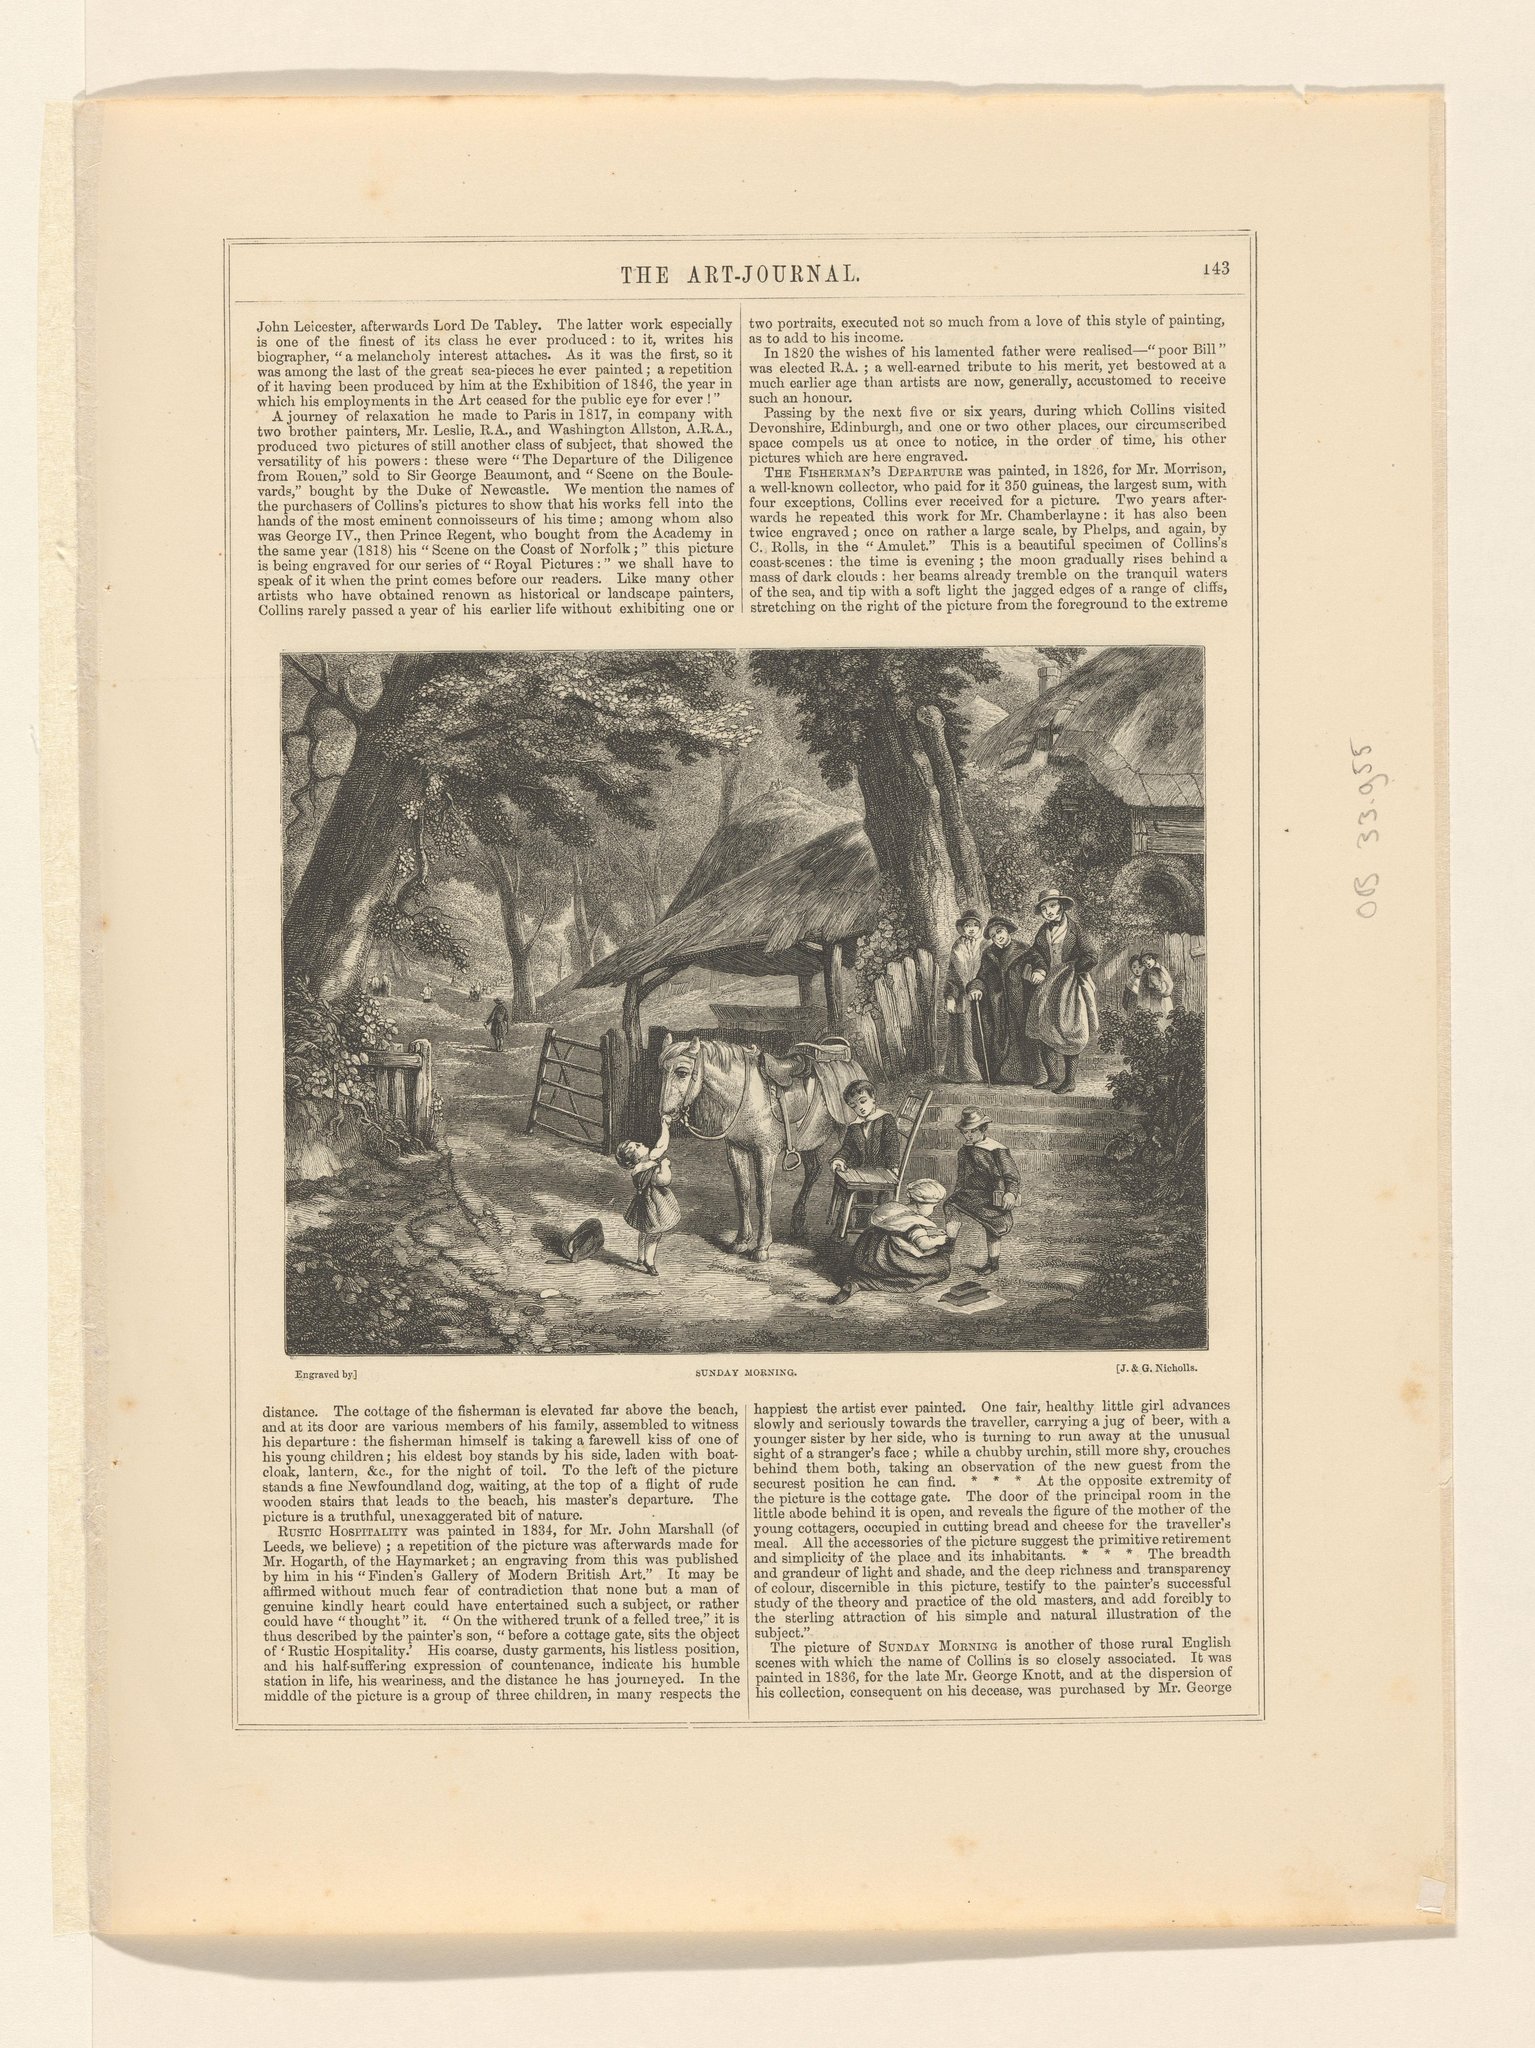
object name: print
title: Familie met lam bij een huis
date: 1855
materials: paper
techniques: letterpress printing, engraving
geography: london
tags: lamb, buying and selling, family life at home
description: Prent uit: The Art Journal (1855), 1855, p. 144.